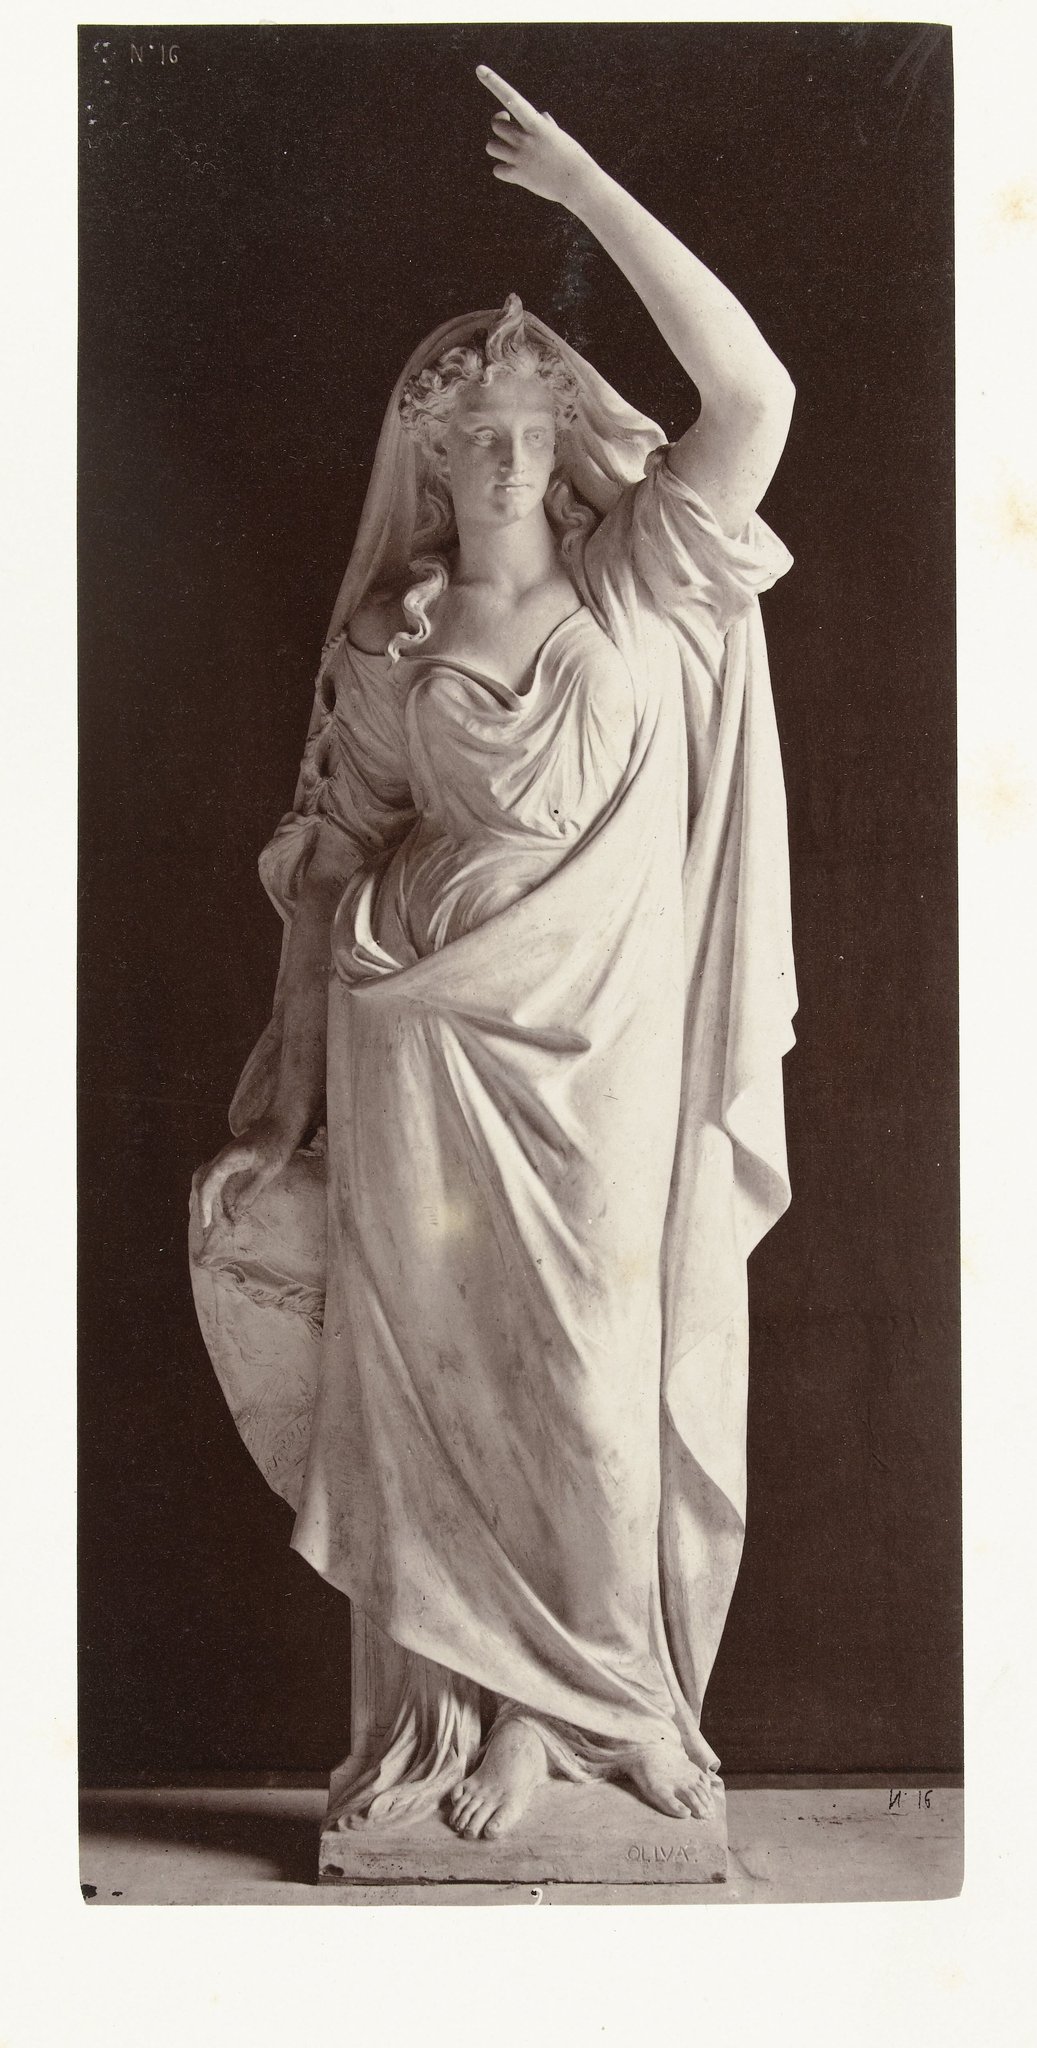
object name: photograph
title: 16. Le nouvel Opéra de Paris. Statues decoratives.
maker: louis-emile durandelle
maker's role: fotograaf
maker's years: 1839-1917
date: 1878-1881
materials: photographic support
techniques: albumen print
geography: paris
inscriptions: number: ‘16’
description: bij boek in Bibliotheek RMA, Zie Frizot, pp. 217-223, vgl G. Vicaire, Manuel de l'amateur de livres du XIXe siècle, vol. 3, column 870.